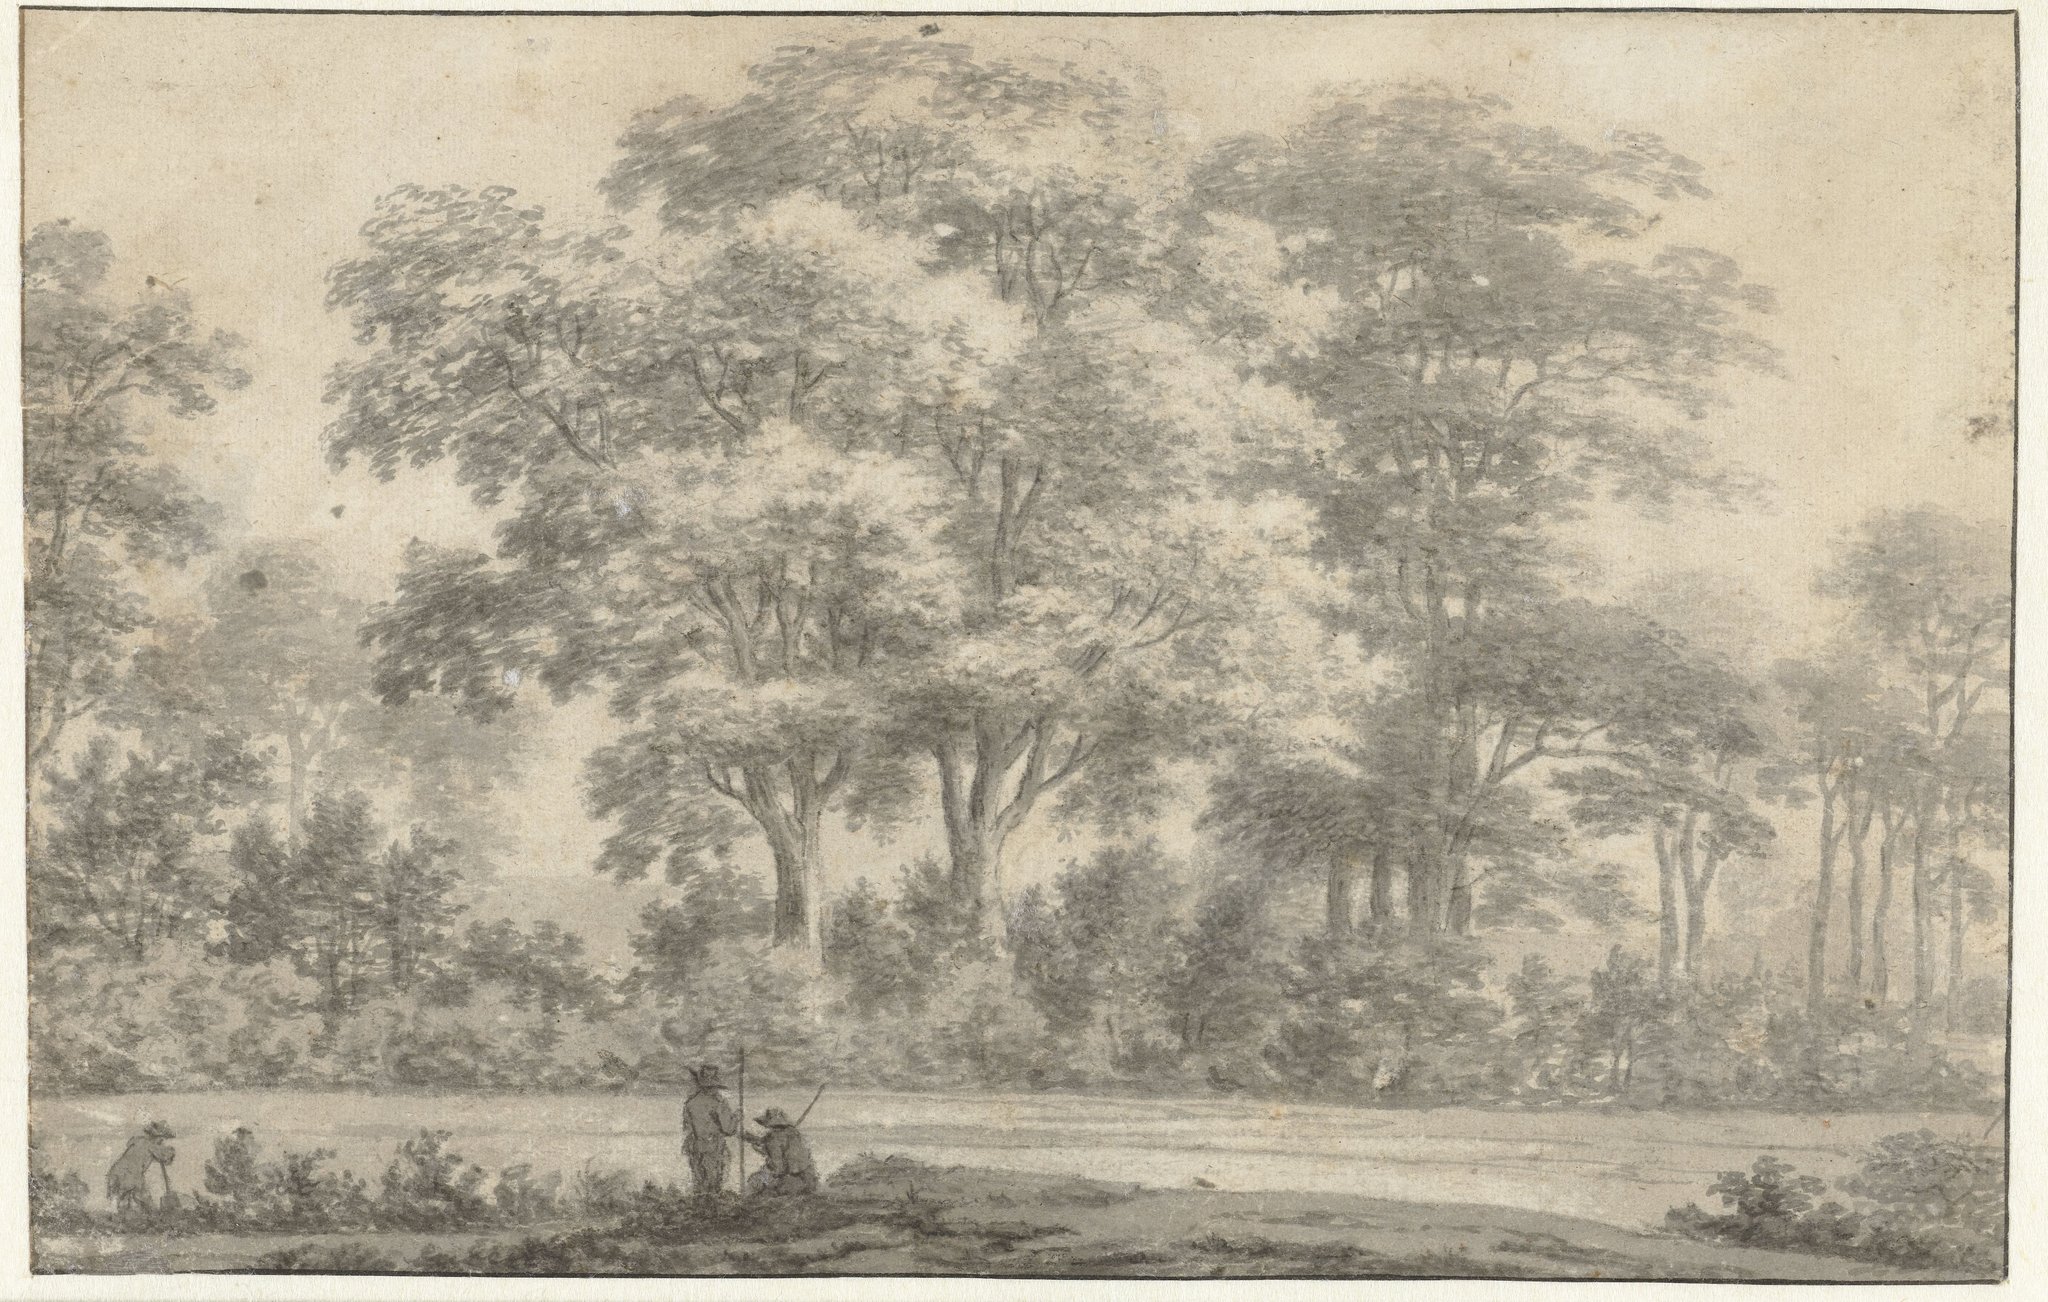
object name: drawing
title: Boomgroep aan de overzijde van een open plek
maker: joris van der haagen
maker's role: draughtsman, painter, print maker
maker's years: 1615-1669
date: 1625-1669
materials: chalk, paper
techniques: brush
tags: forest, wood